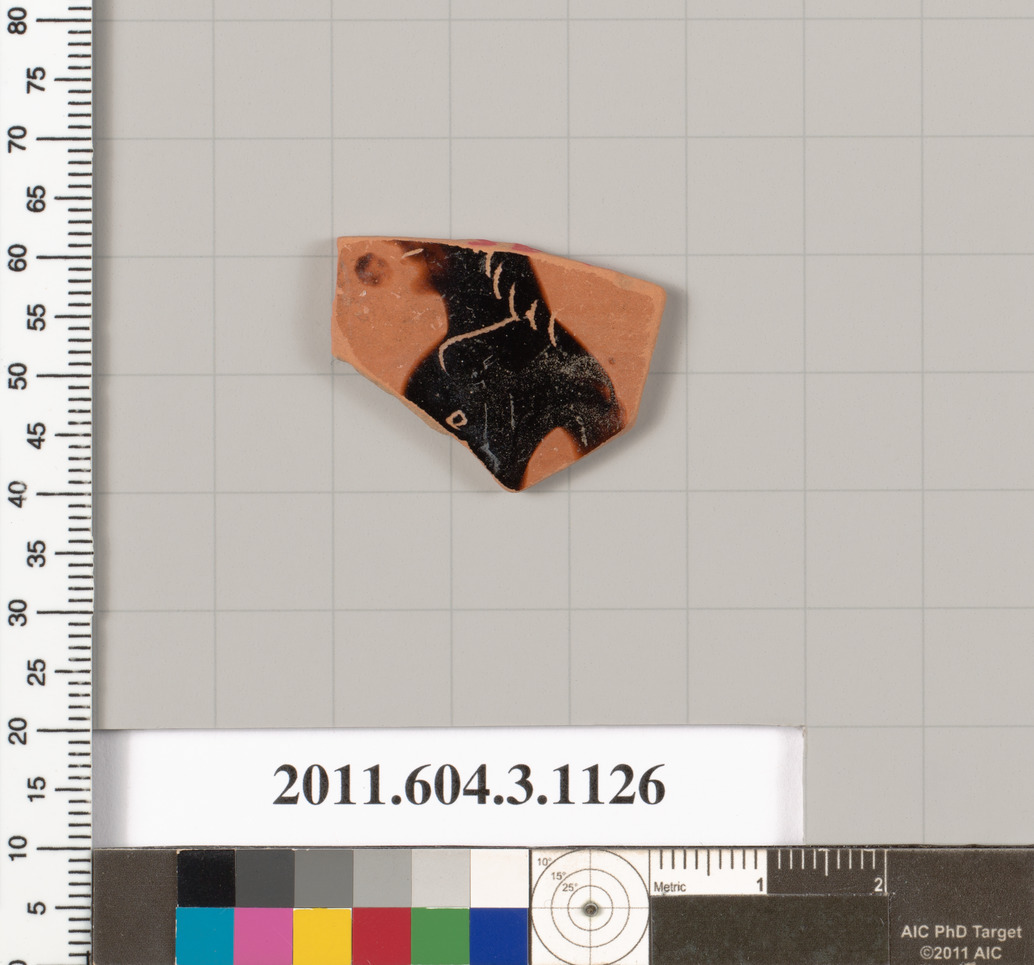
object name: mastoid or kyathos fragment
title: Terracotta fragment of a mastoid (drinking cup with narrow base) or a kyathos (cup-shaped ladle)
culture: greek, attic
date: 534-468 BCE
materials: terracotta